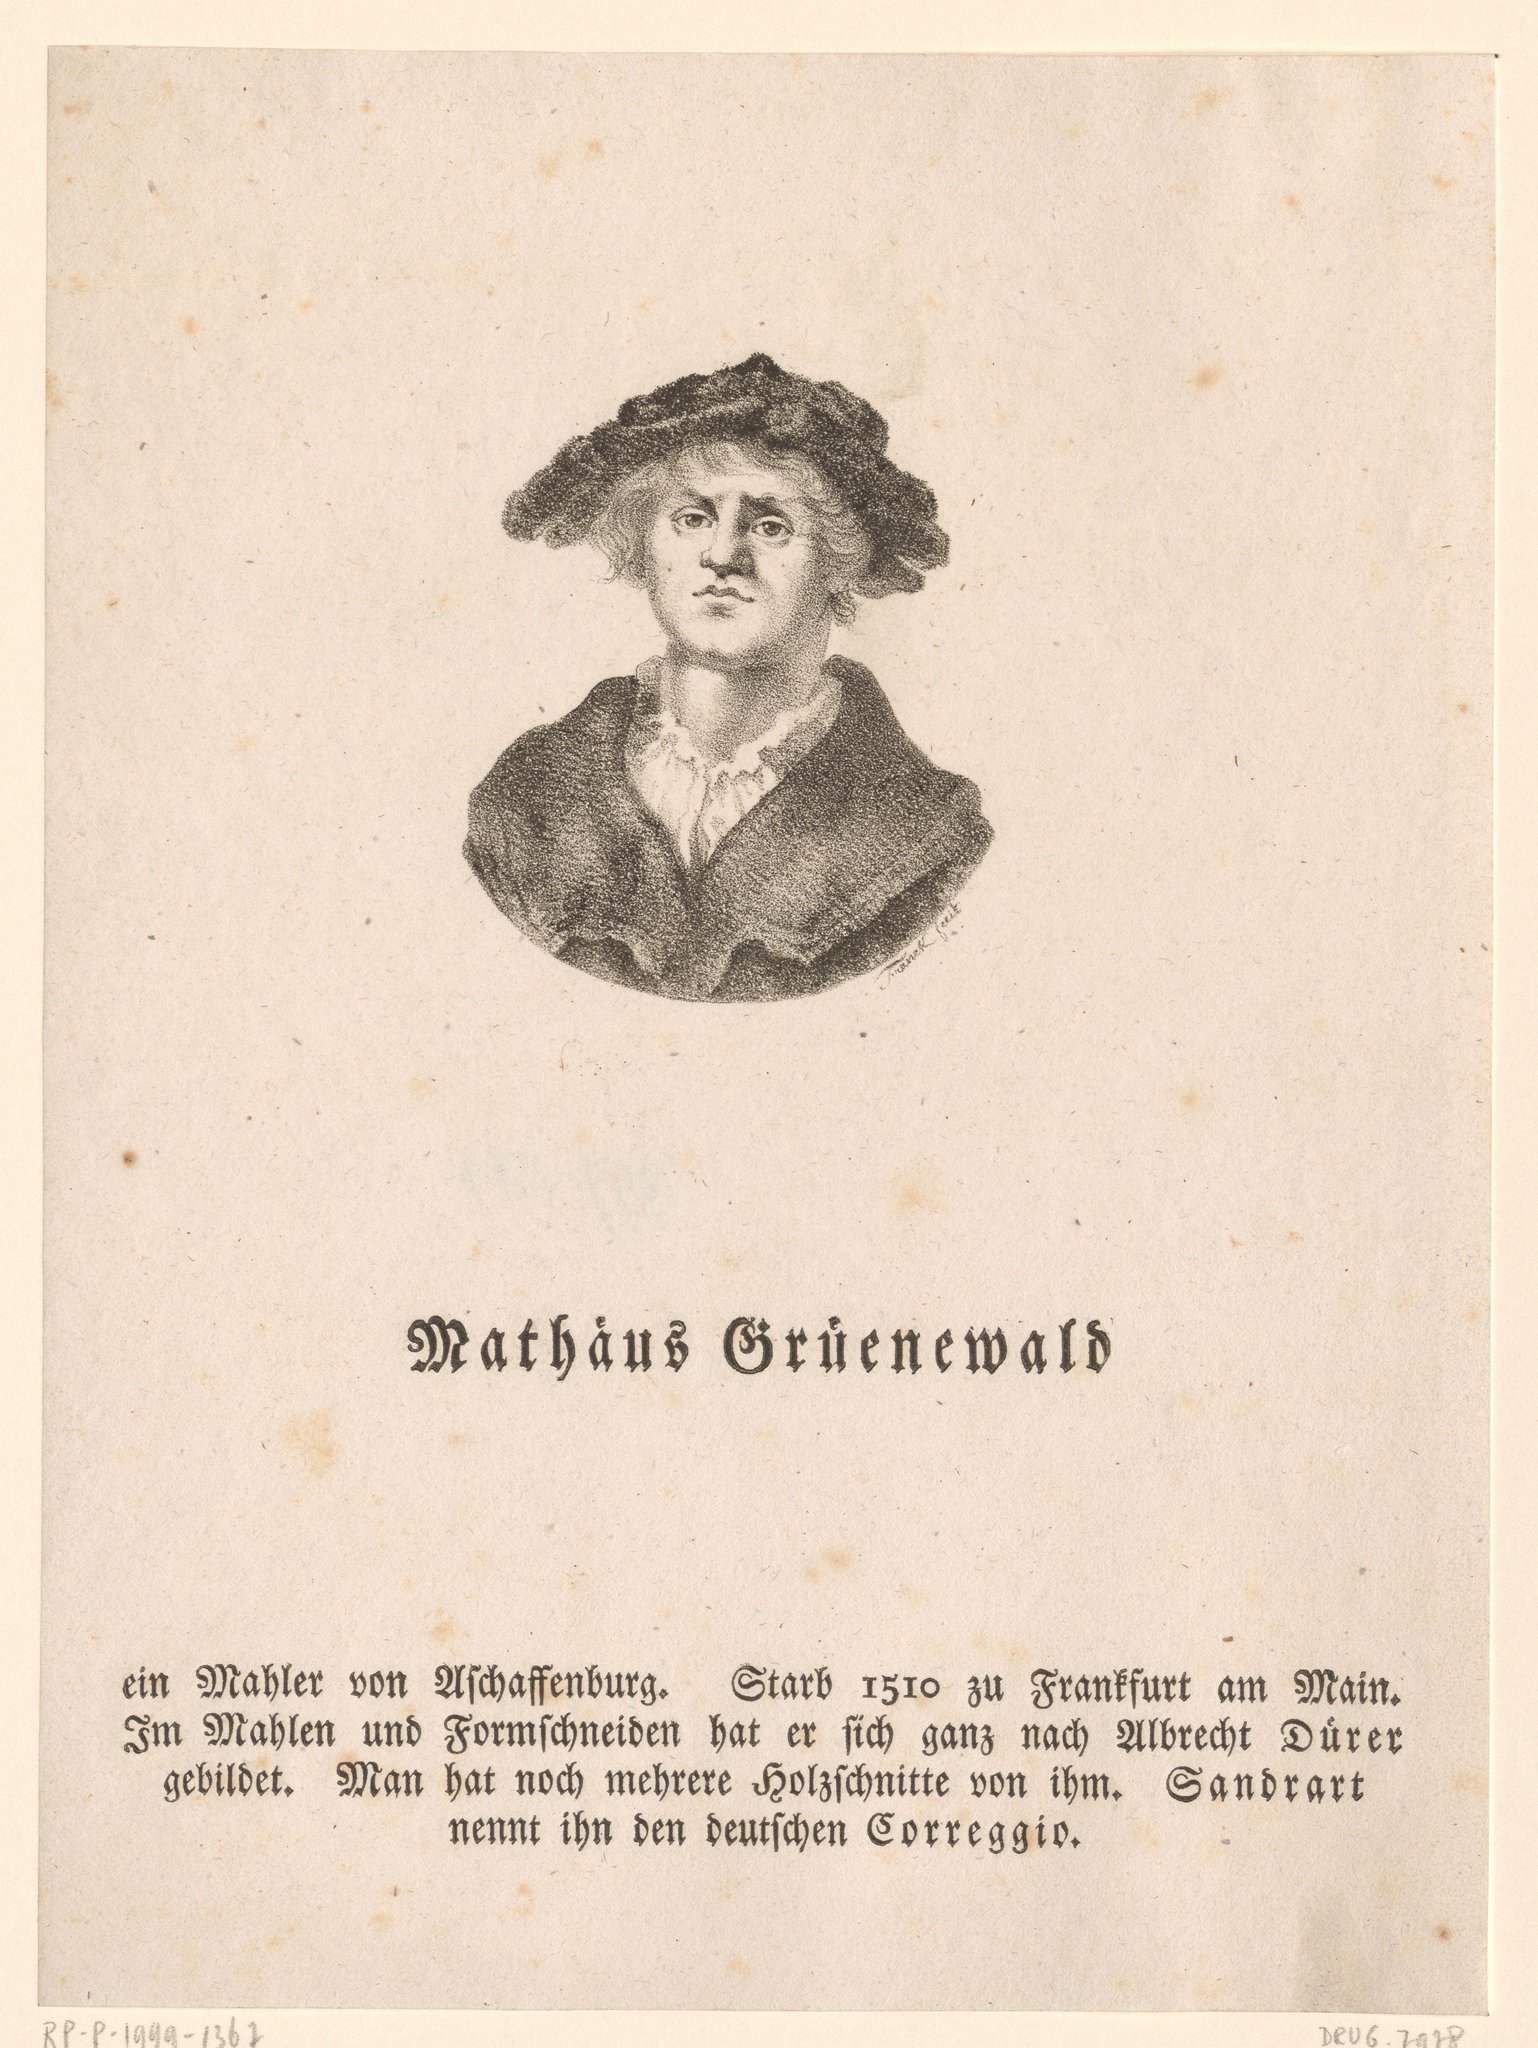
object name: print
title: Portret van Matthias Grünewald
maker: françois marie louis franck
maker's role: fotograaf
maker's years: 1816-1906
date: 1826-1906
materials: paper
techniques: lithograph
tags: painter, draughtsman, matthias grünewald, sculpture (+ portrait, self-portrait of artist), historical persons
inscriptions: collector's mark: Lugt 2760, : ‘Mathäus Grüenewald/ ein Mhler von Aschaffenburg. Starb 1510 zu Frankfurt am Main/ Im Mahlen (...)/ nennt ihn den deutschen Correggio.’, collector's mark: Lugt 2228